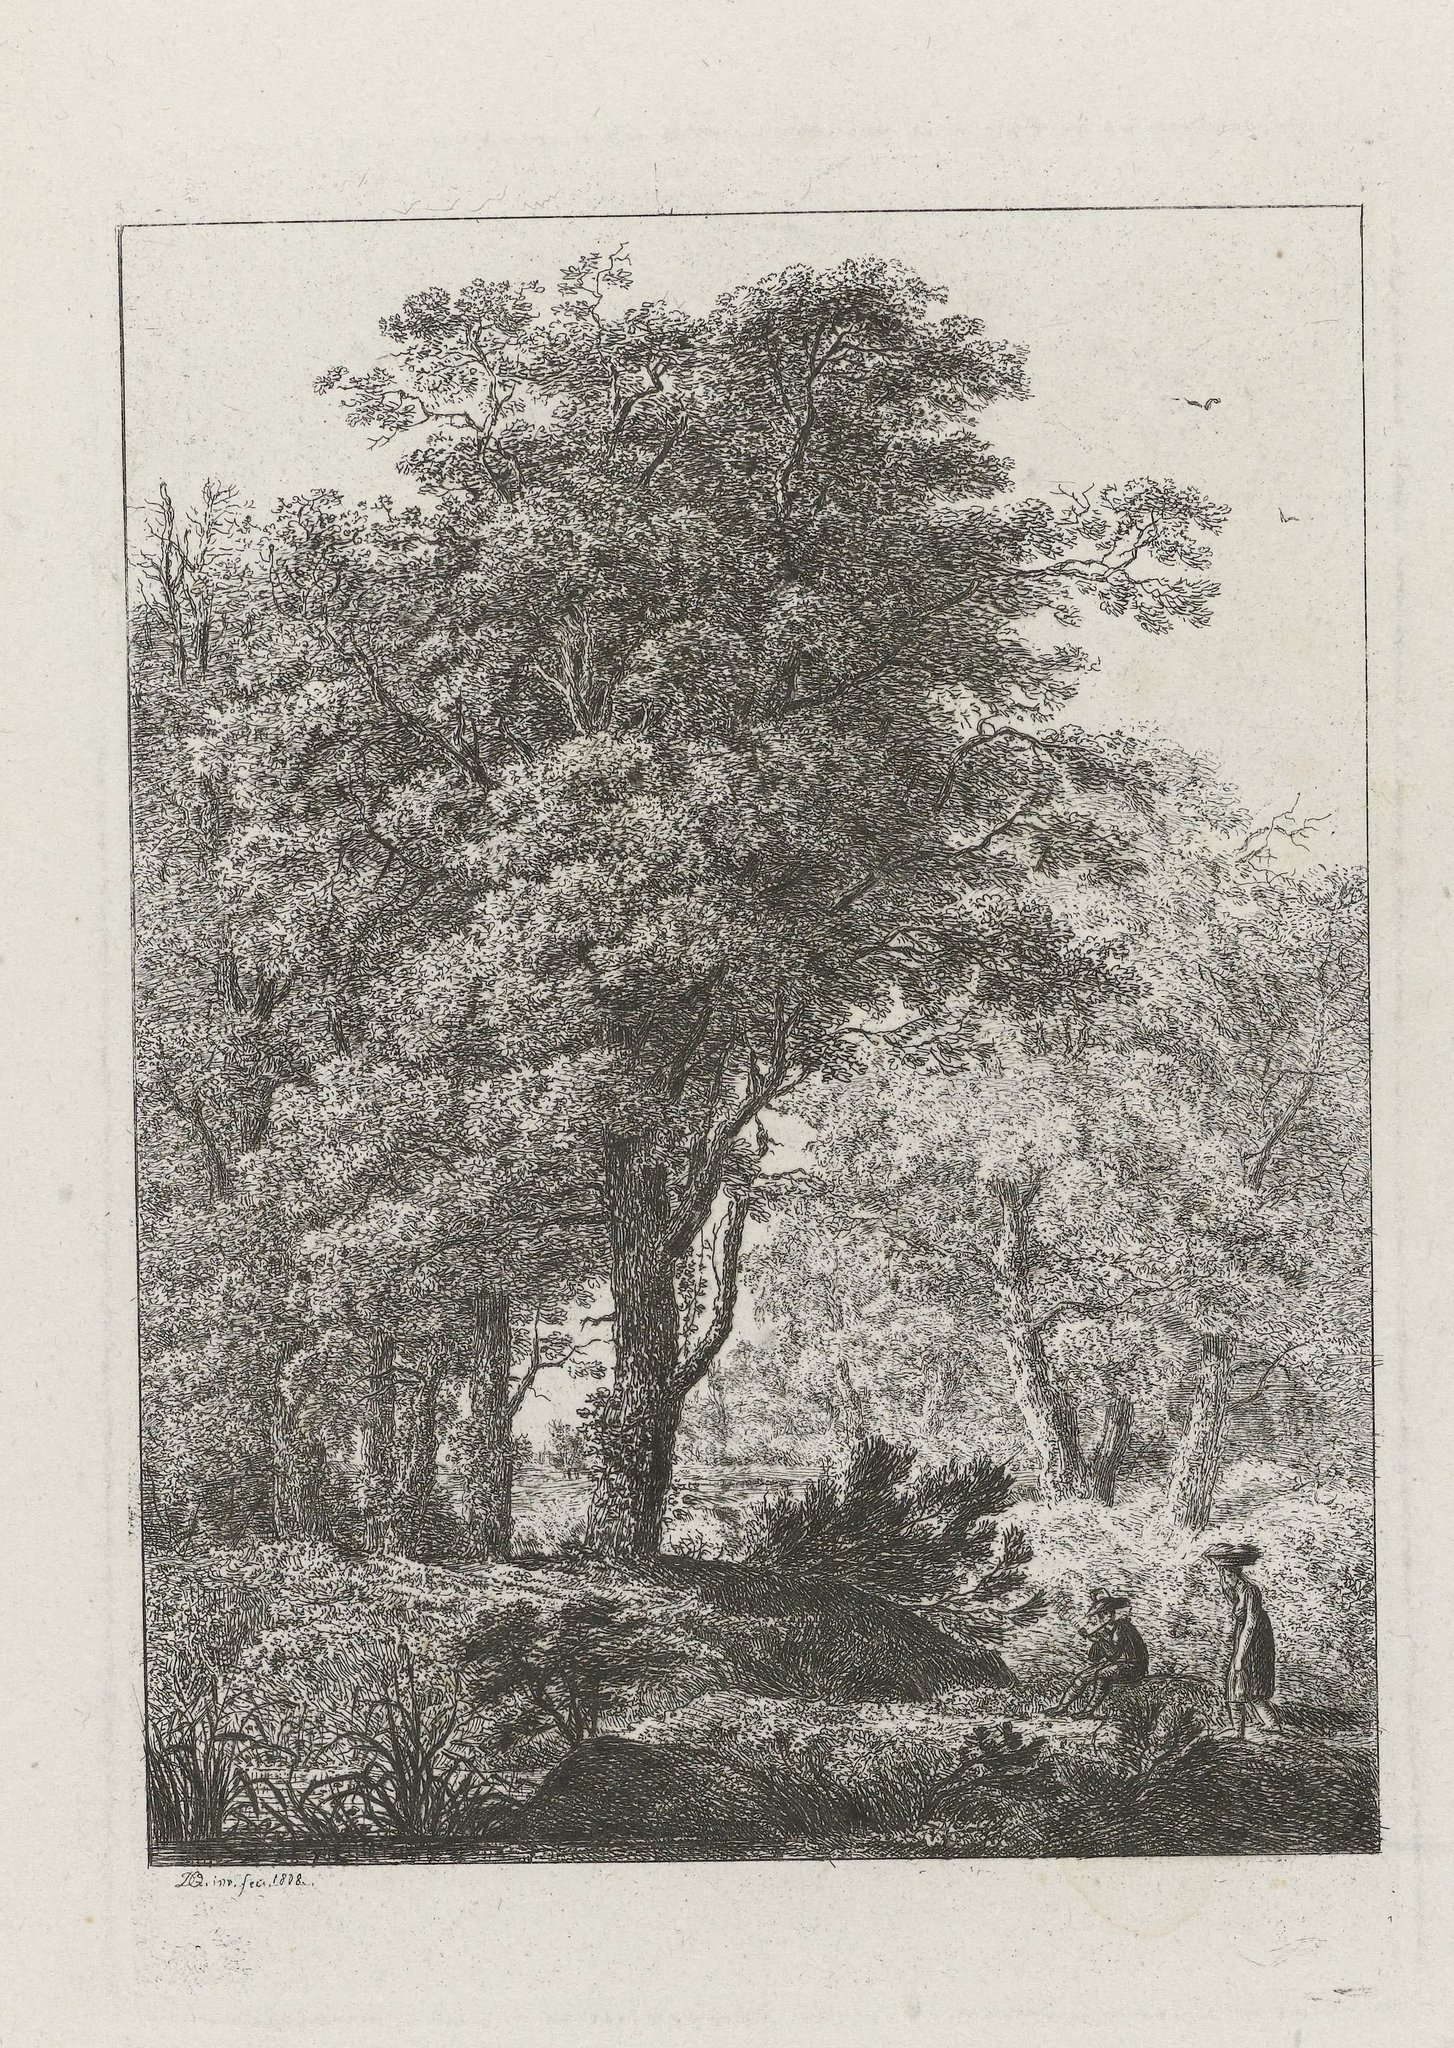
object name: print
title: Twee figuren in een bos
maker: johann velten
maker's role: print maker, publisher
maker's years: 1784-1864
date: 1808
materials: paper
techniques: etching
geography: karlsruhe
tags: forest, wood (+ landscape with figures, staffage)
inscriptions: collector's mark: Lugt 2228, collector's mark: Lugt 2760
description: Deze prent maakt deel uit van een serie van 24 prenten.